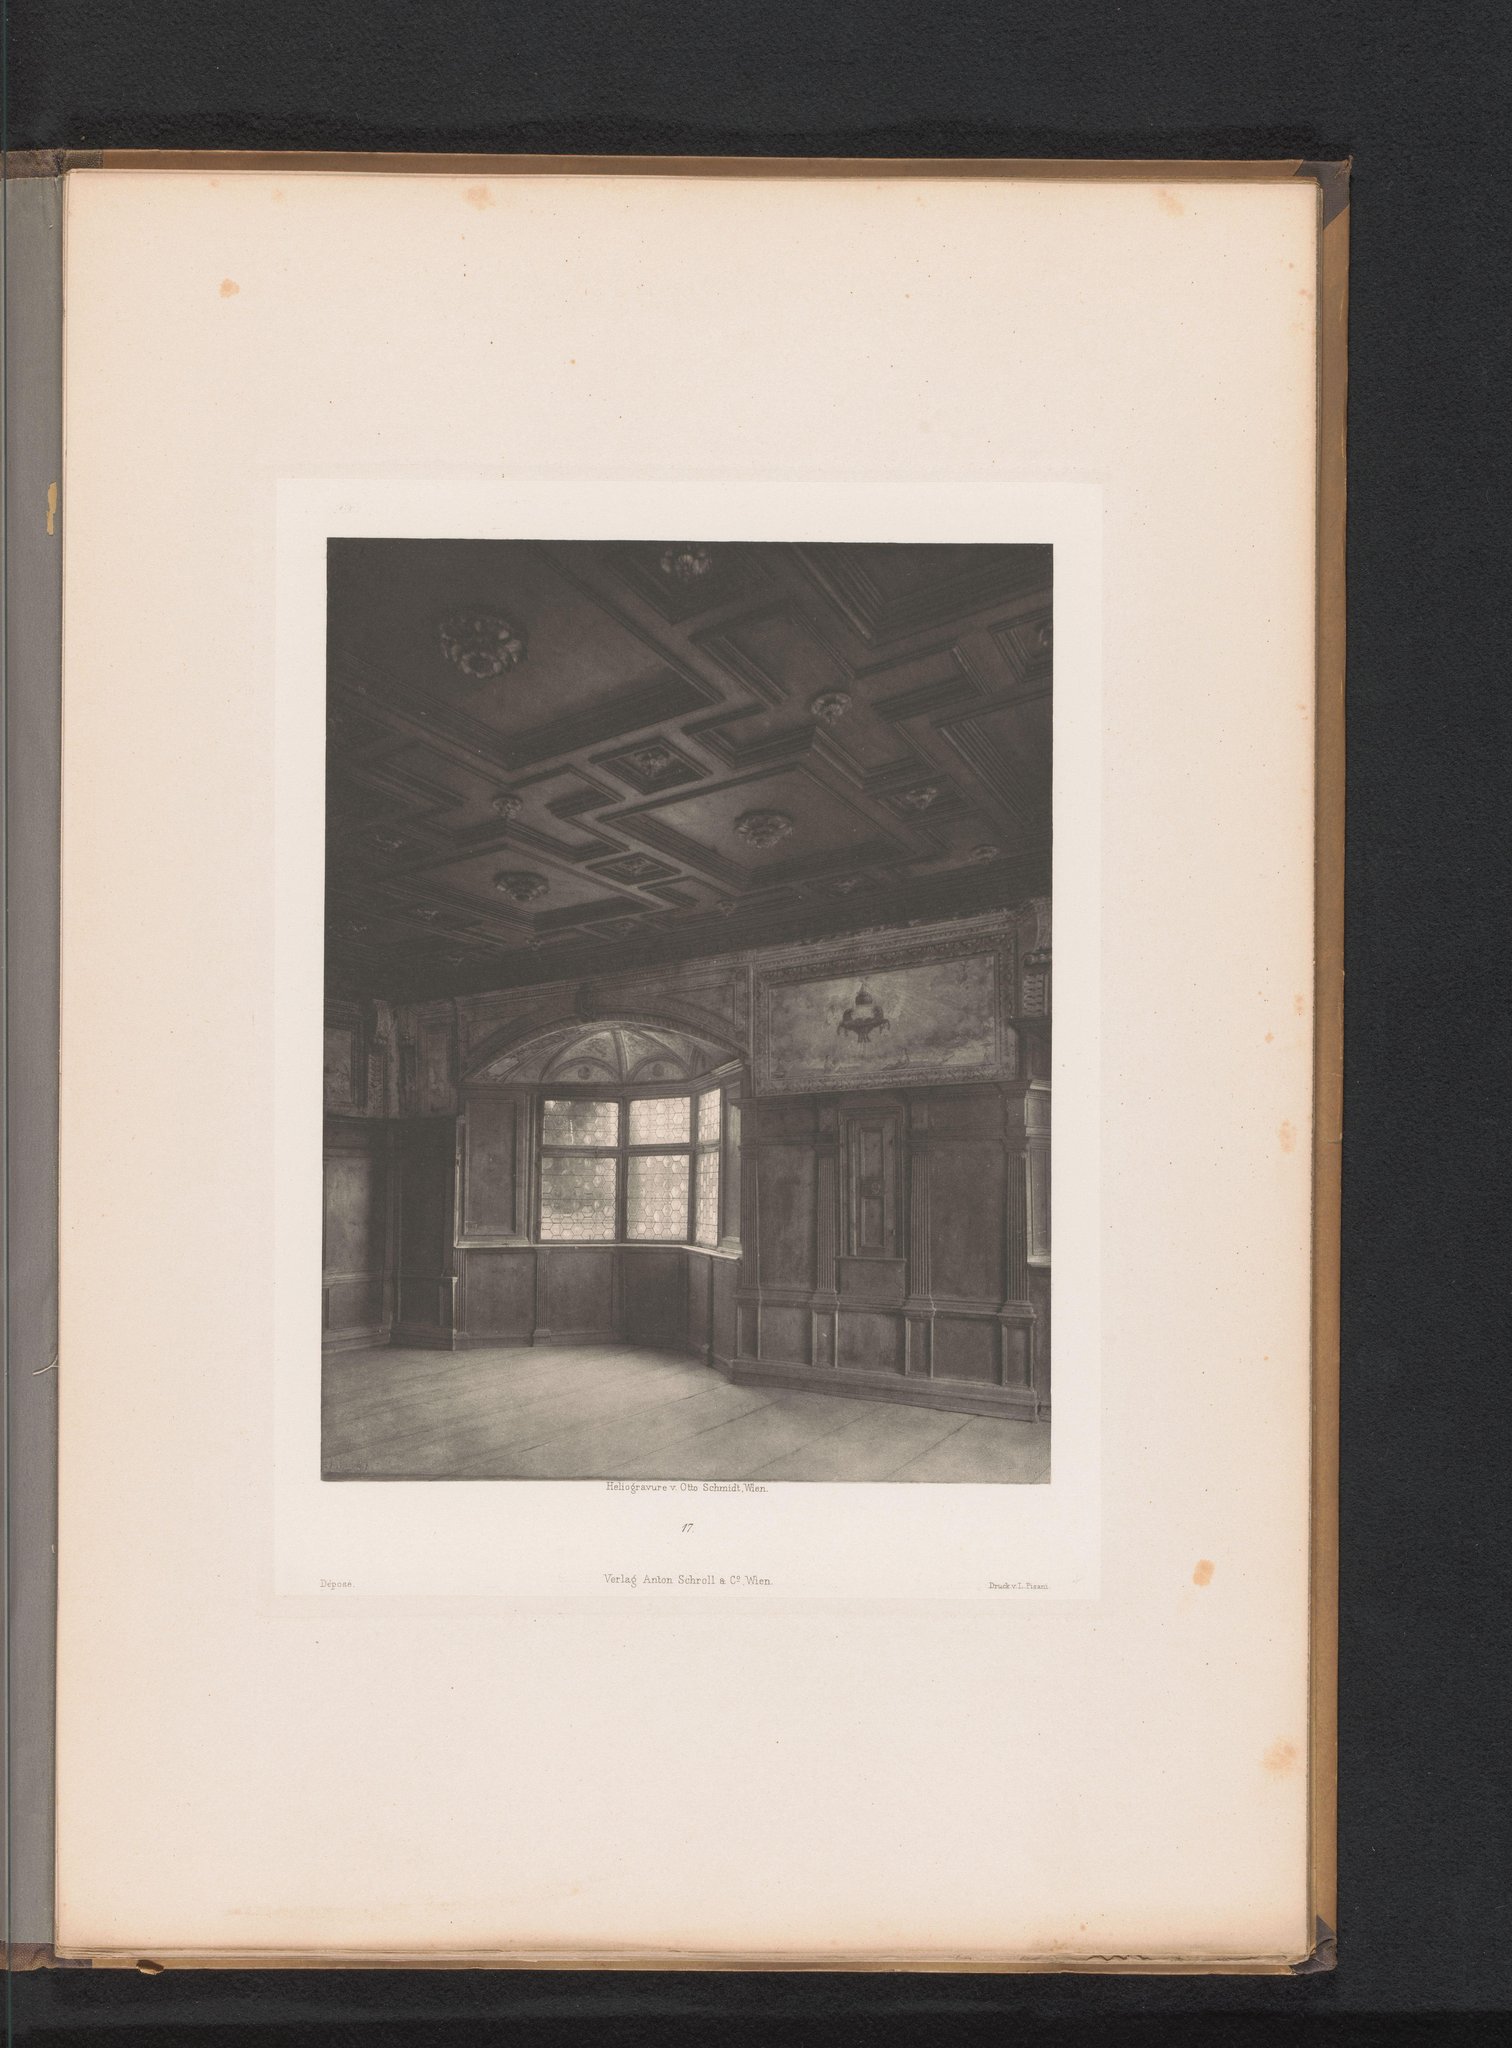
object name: photomechanical print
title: Gezicht op een kamer met erker in Slot Velthurns bij Bressanone, Italië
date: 1886-1891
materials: paper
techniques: photoaquatint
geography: slot velthurns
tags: castle - aa - civic architecture: inside, bay-window, oriel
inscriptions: inscription: ‘Déposé.’, number: ‘17.’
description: Deze prent maakt deel uit van een omslag met dertig prenten en drie tekstbladen.